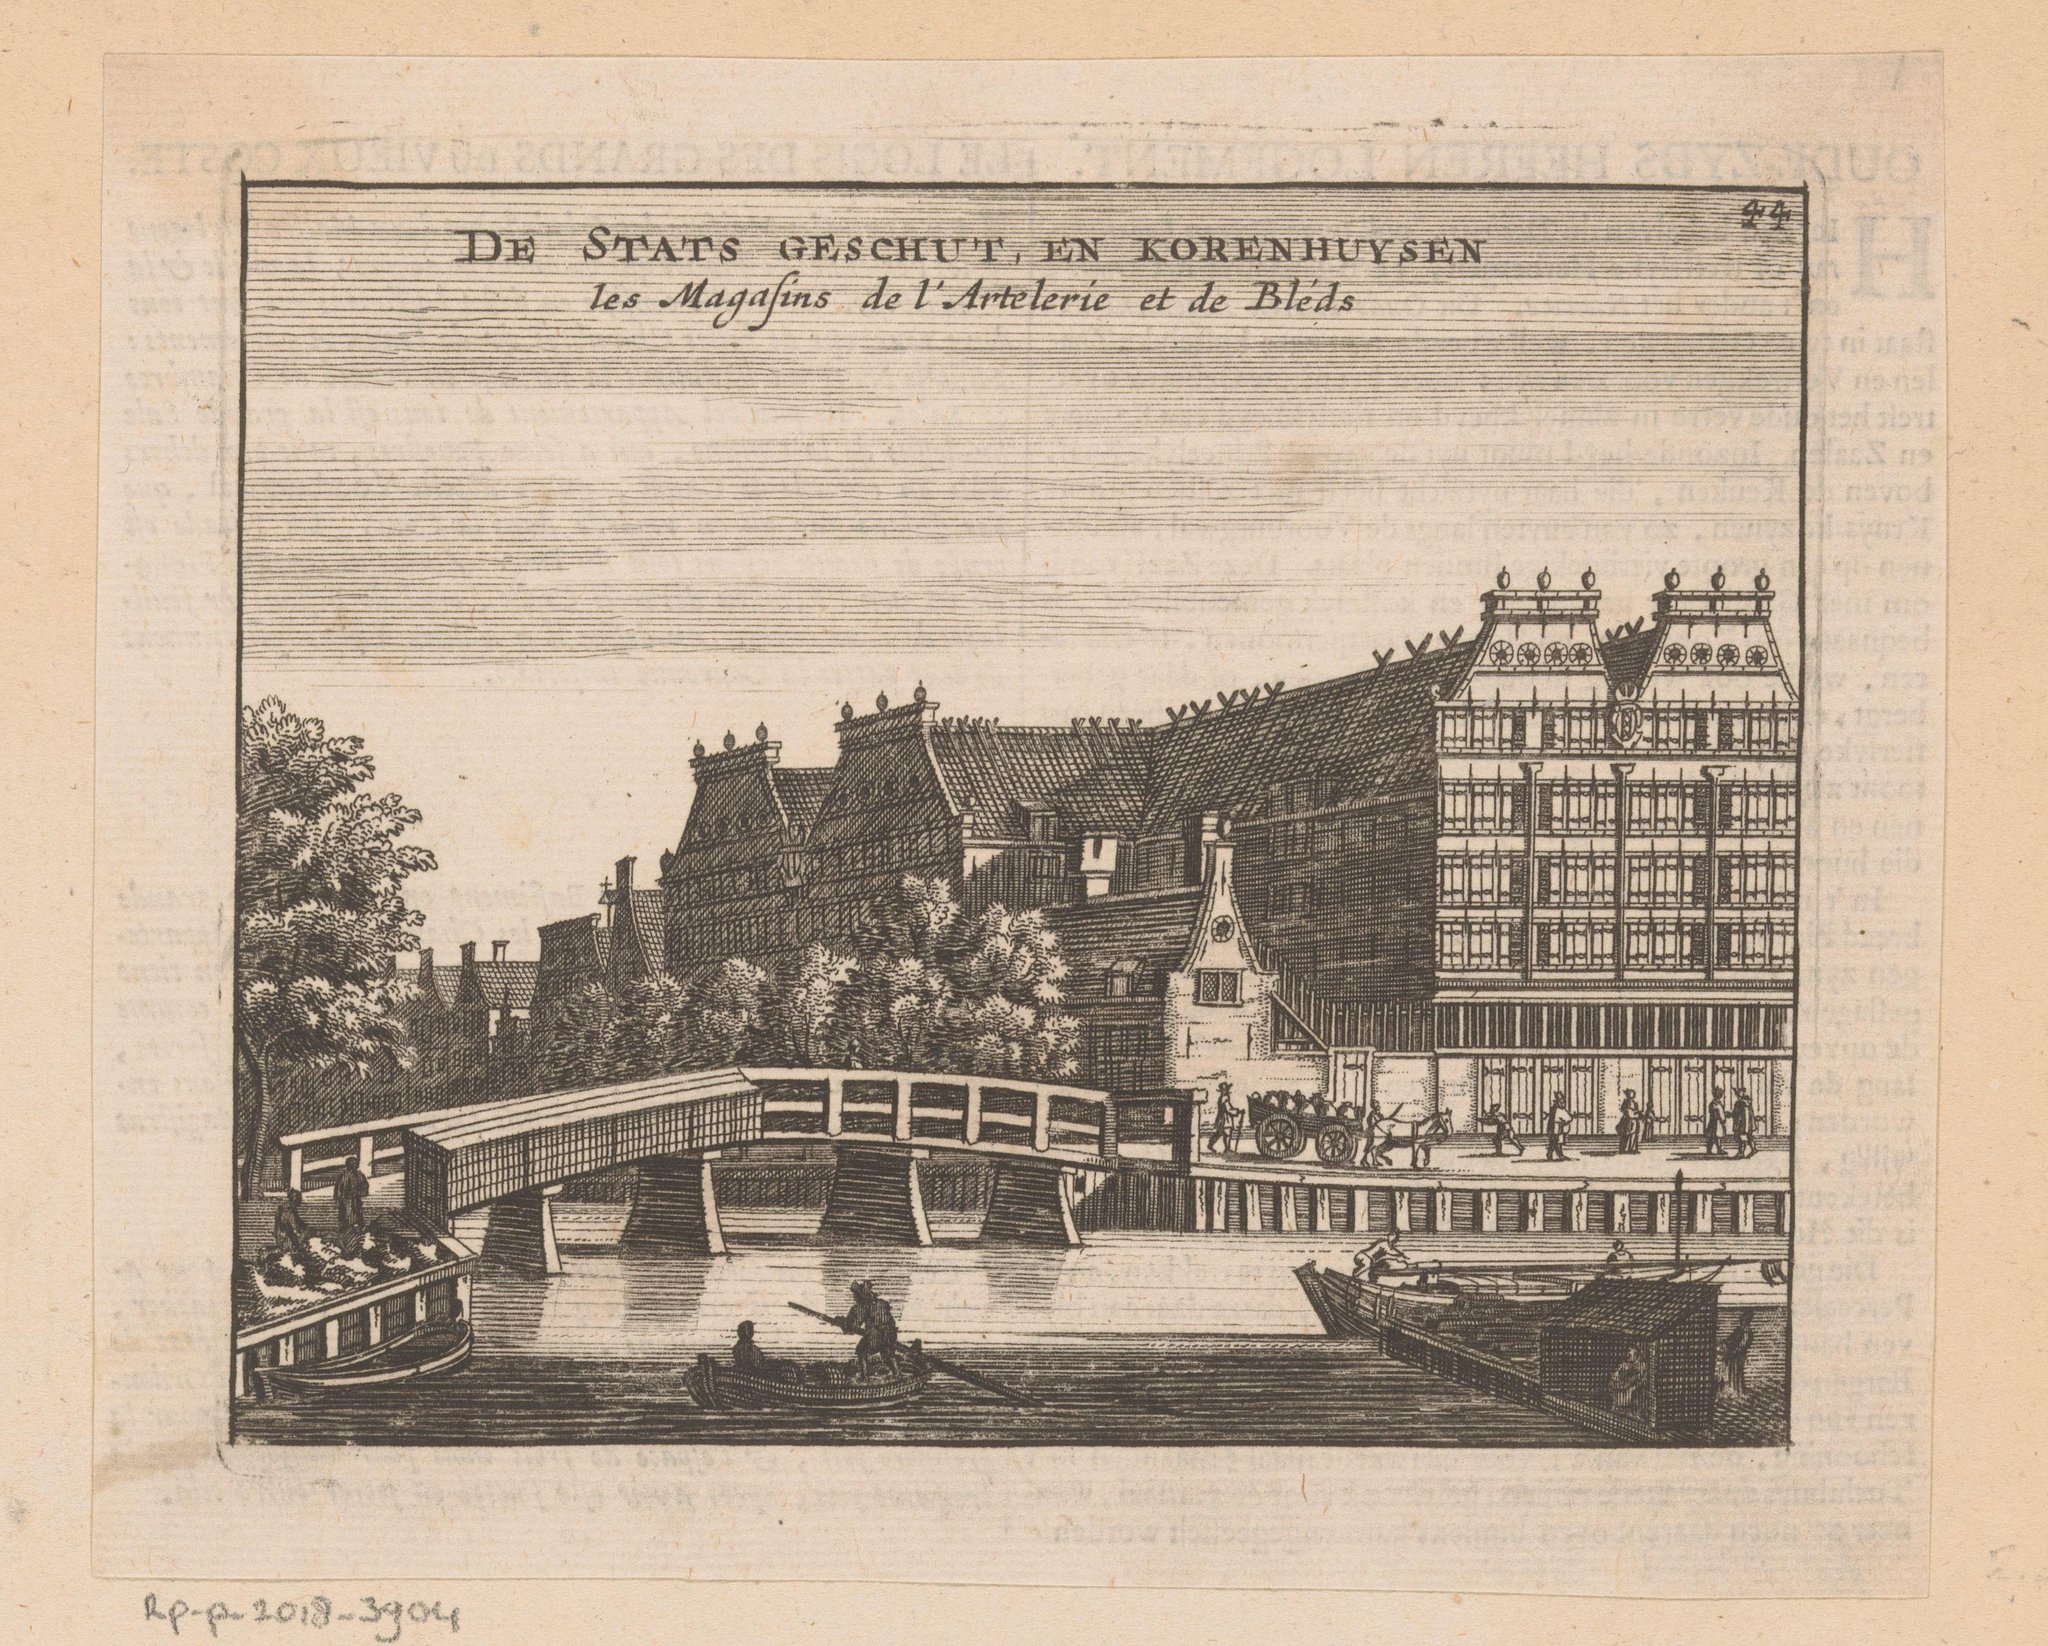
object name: book illustration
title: De Stats geschut en korenhuysen / Les Magasins de l'Artelerie et de Bléds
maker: Anonymous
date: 1650-1700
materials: paper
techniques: etching, letterpress printing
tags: bridge in city across river, canal, etc., amsterdam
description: Prent verschenen in: Amsterdam met der zelver Voornaamste Gebouwen / D'Amsterdam et deses Principaux Bastimens. S.l. s.n., [1665].